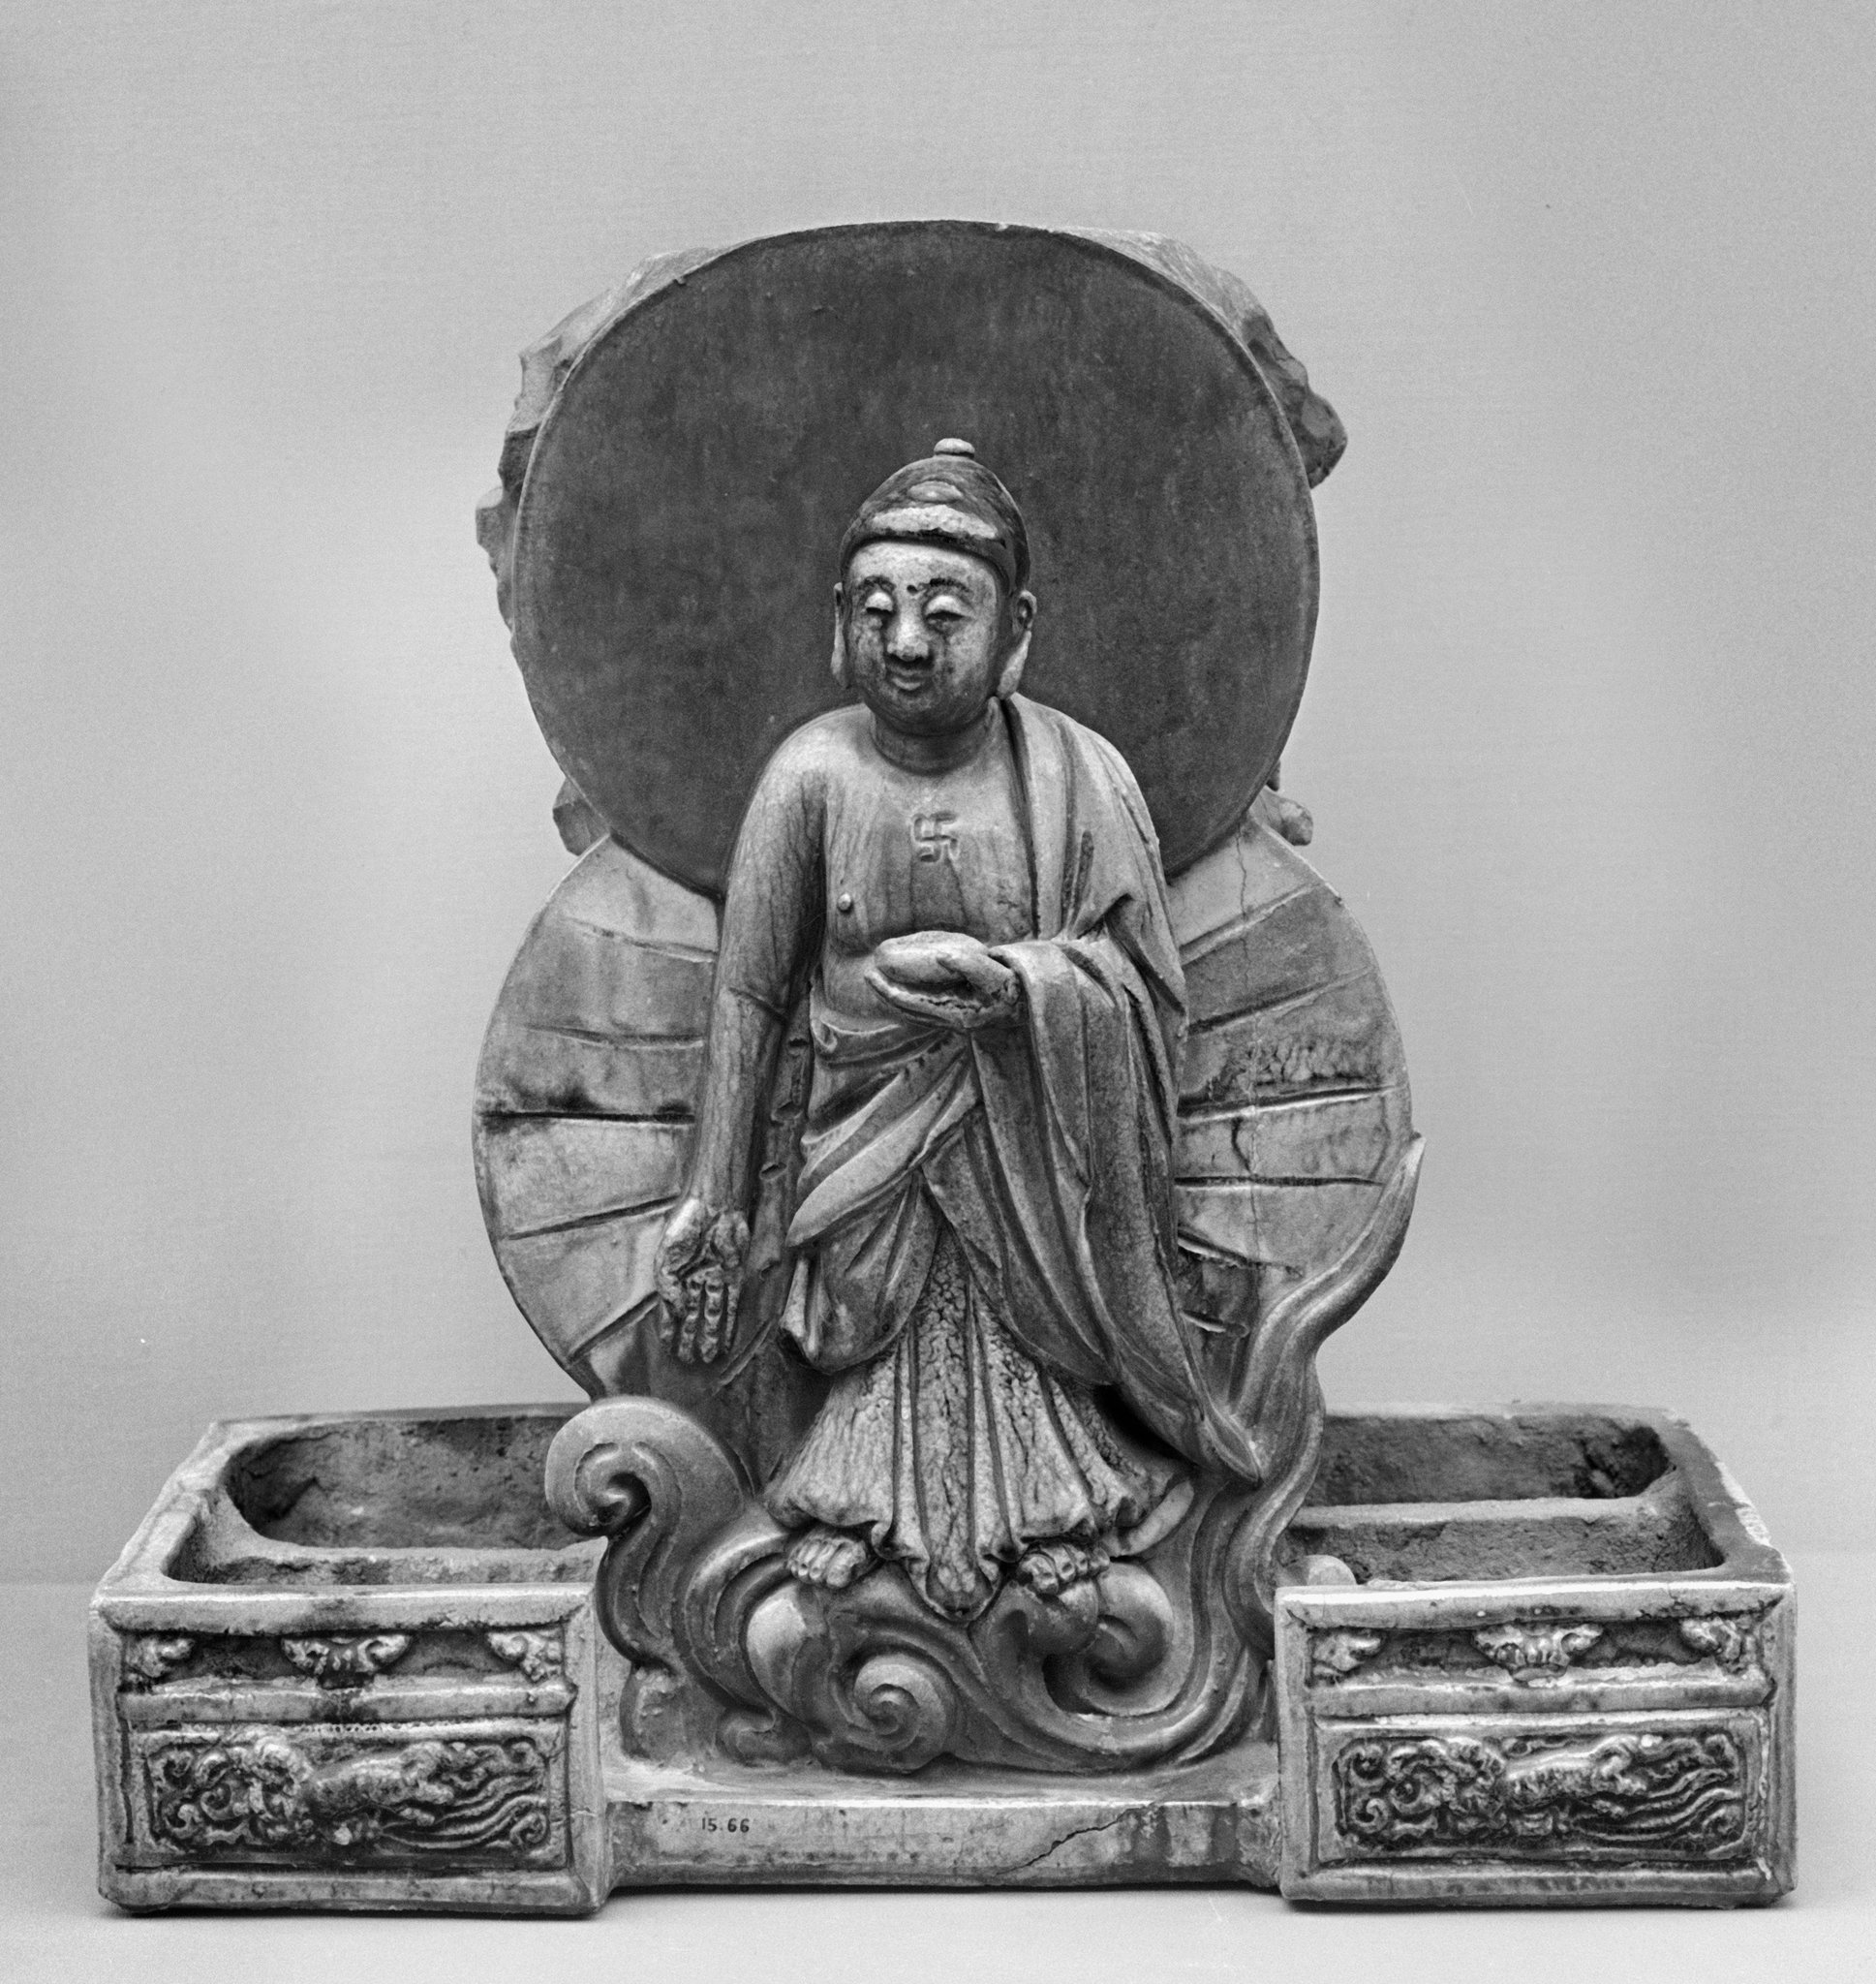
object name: roof tile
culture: chinese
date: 1368-1644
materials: pottery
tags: men